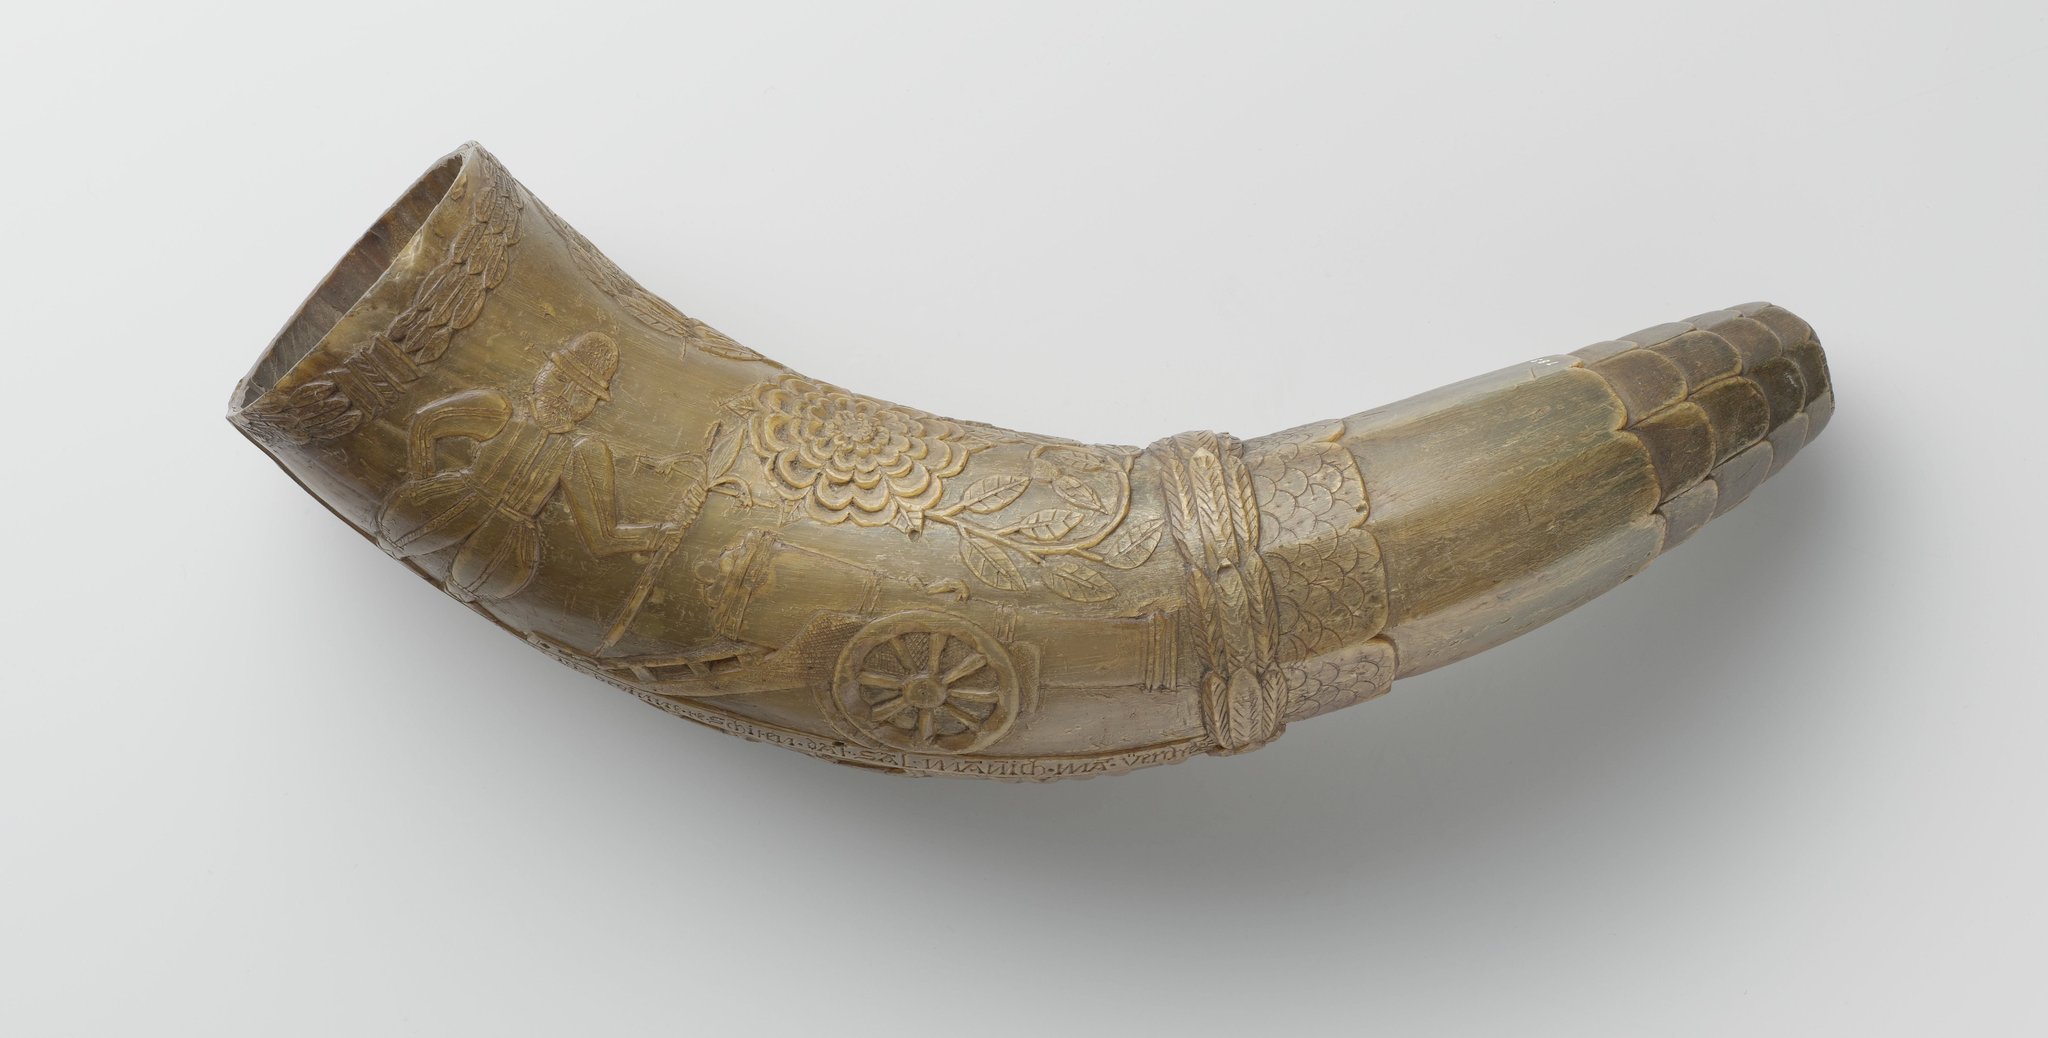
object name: powder horn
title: Gunner’s powder horn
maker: Anonymous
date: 1580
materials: horn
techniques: cutting, engraving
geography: netherlands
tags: firearms: cannon, netherlands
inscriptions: inscription, inscription: ‘ano 1580 // E # i’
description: This powder horn is made from an almost complete cow horn. The decoration is fitting: a gunner with a slow match on a staff (linstock) standing by a heavy field cannon. On the other side a deer is fleeing from a hunter with his dogs. The stopper to close the open end of the horn has been lost. Translation of inscription: When I begin to fire, many shall feel my ire.